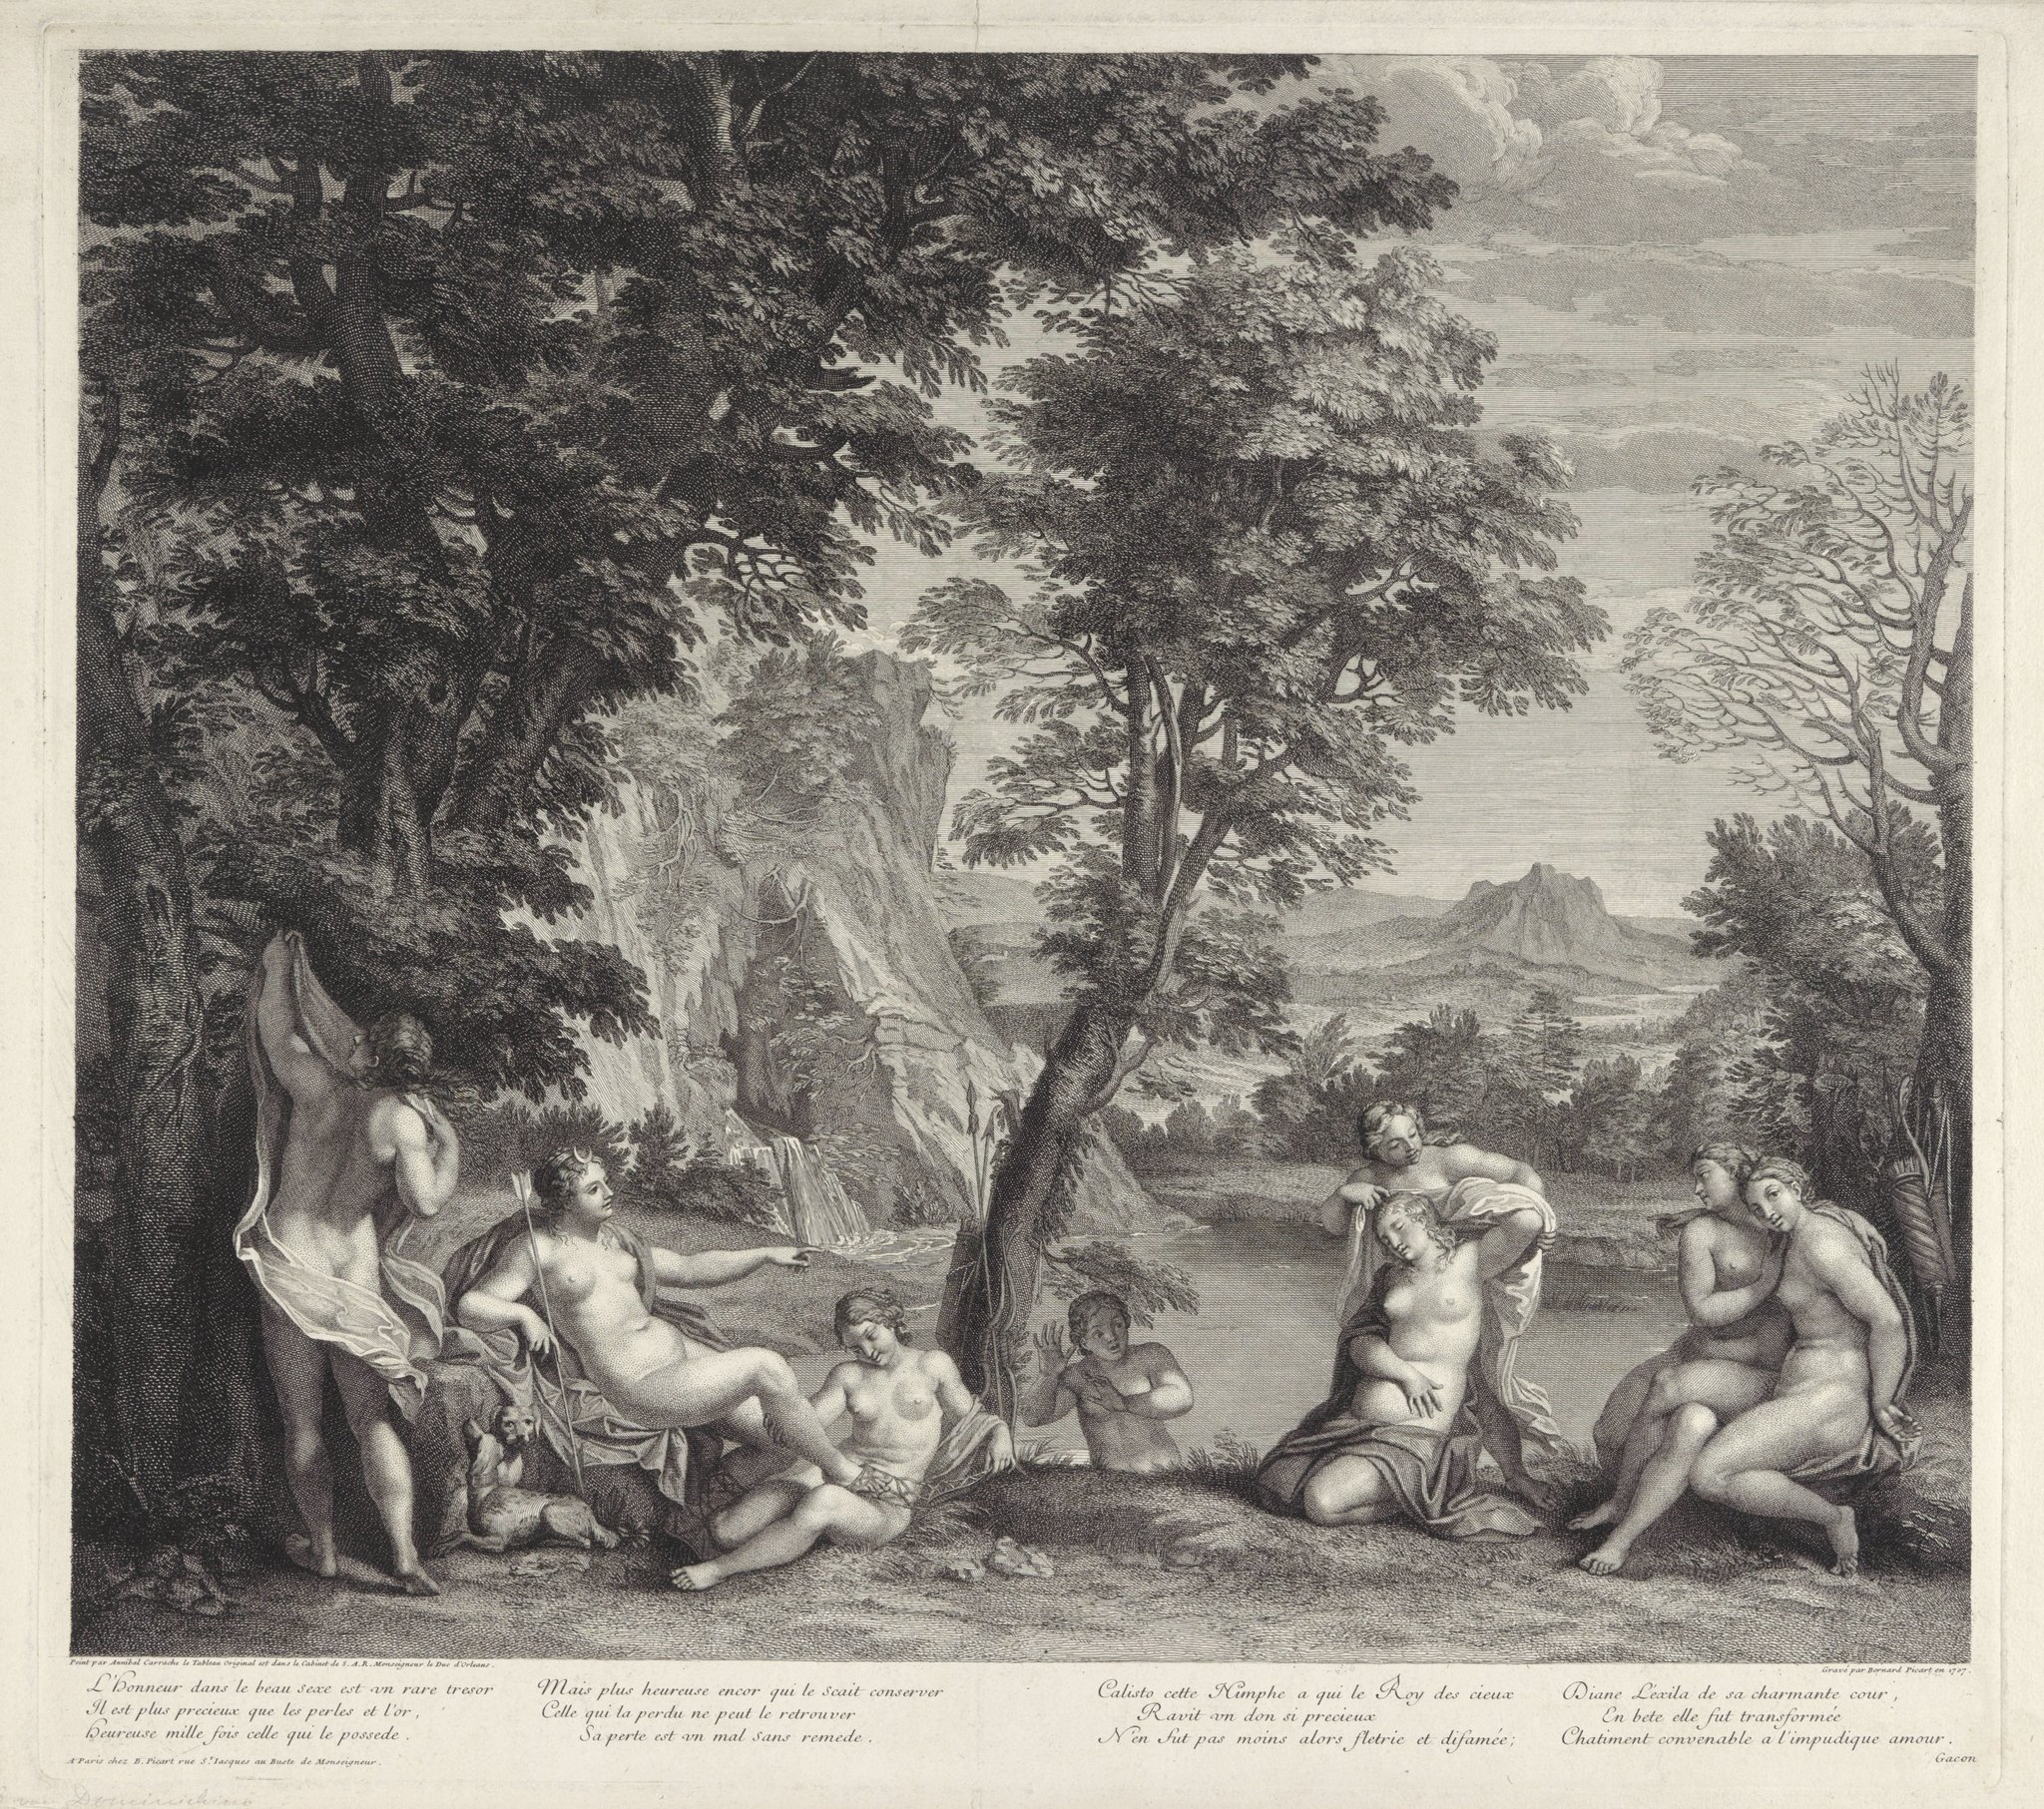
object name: print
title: Diana en Callisto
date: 1707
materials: paper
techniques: engraving, etching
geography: paris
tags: diana with her nymphs discovers the pregnancy of callisto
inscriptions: collector's mark: Lugt 240, inscription: ‘NB van Dominichino’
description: Diana, met de maansikkel op haar hoofd, ontdekt de zwangerschap van de nimf Callisto. Een andere nimf reageert verschrikt. Onderaan in de marge verklarende verzen in het Frans en een verwijzing naar het originele schilderij in de collectie van Filips I van Orléans.